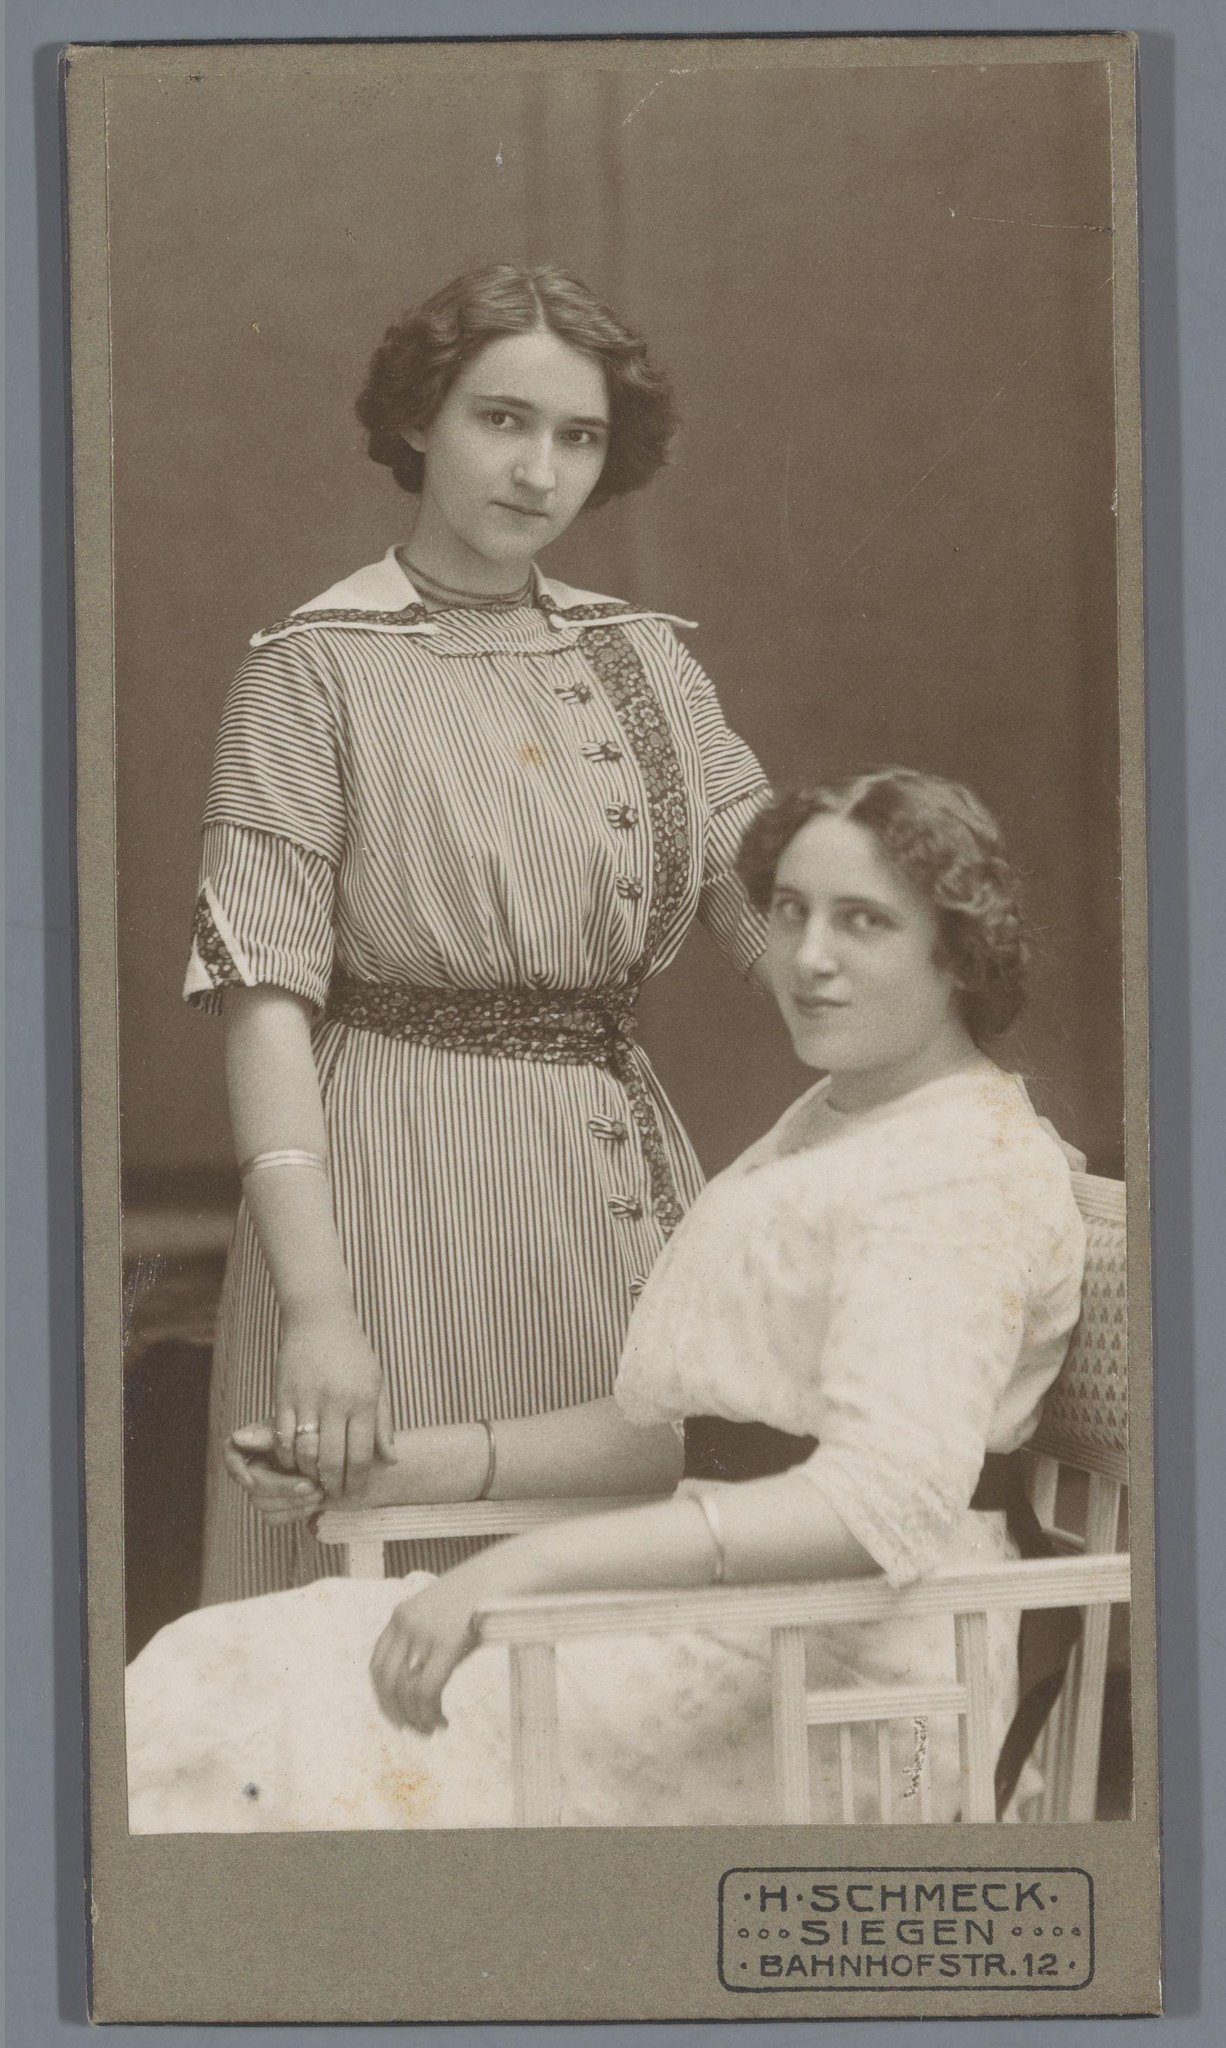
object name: photograph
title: Portret van twee onbekende vrouwen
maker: heinrich schmeck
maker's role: fotograaf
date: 1900-1914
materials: paper, cardboard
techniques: gelatin silver print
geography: siegen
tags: adult woman, anonymous historical person portrayed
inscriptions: inscription: ‘Telephon No 491./ Mehrfach prämiirt./ G. JANSSEN & Co, KÖLN A/R.’, address: ‘SIEGEN/ BAHNHOFSTR. 12.’